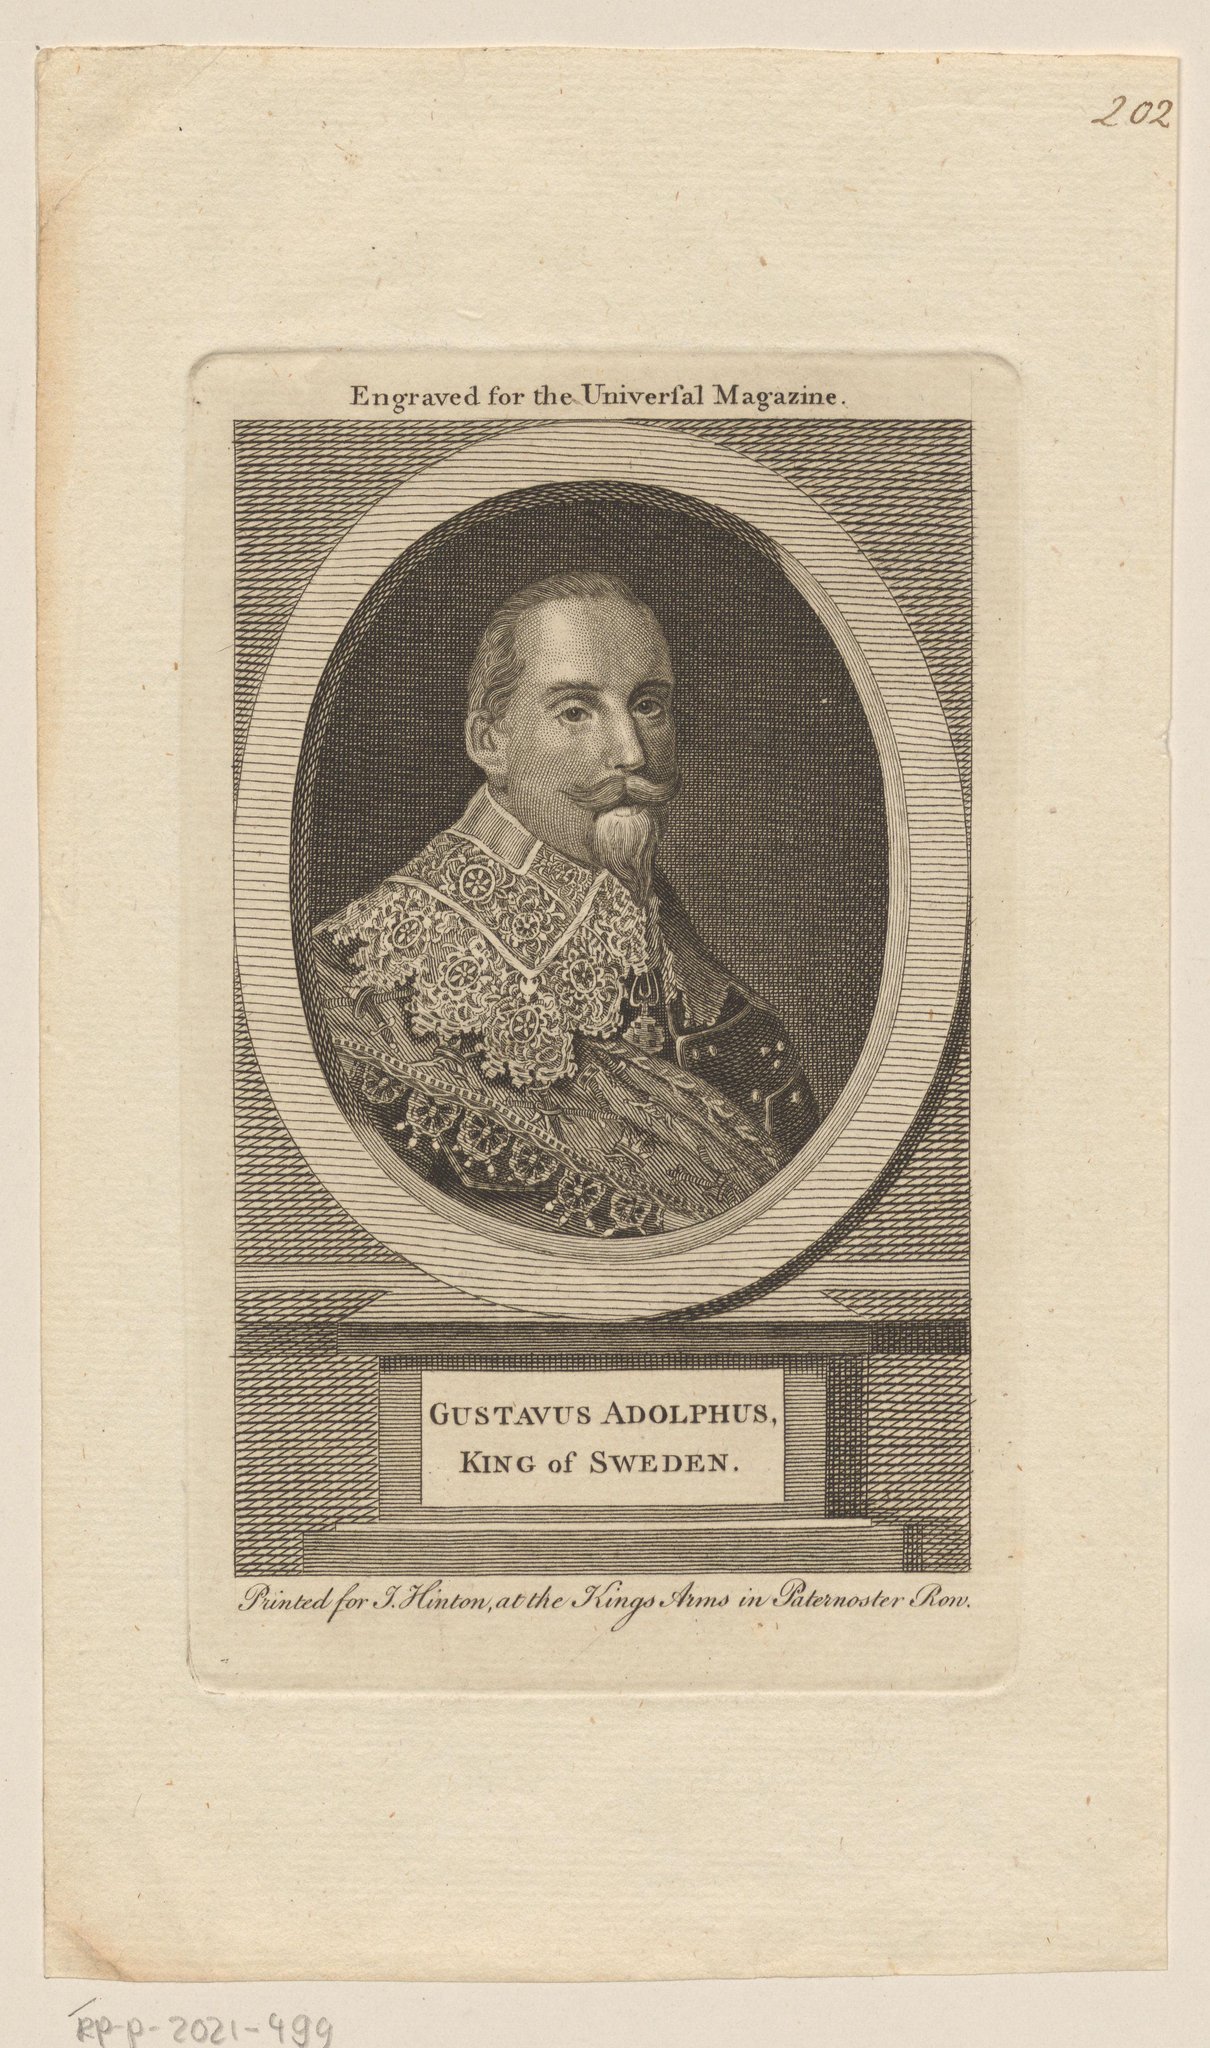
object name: print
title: Portret van Gustaaf II, koning van Zweden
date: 1747-1781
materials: paper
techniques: engraving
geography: london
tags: historical persons, memorial medal, king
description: Prent uit: The Universal Magazine of Knowledge and Pleasure, 1747-1781.